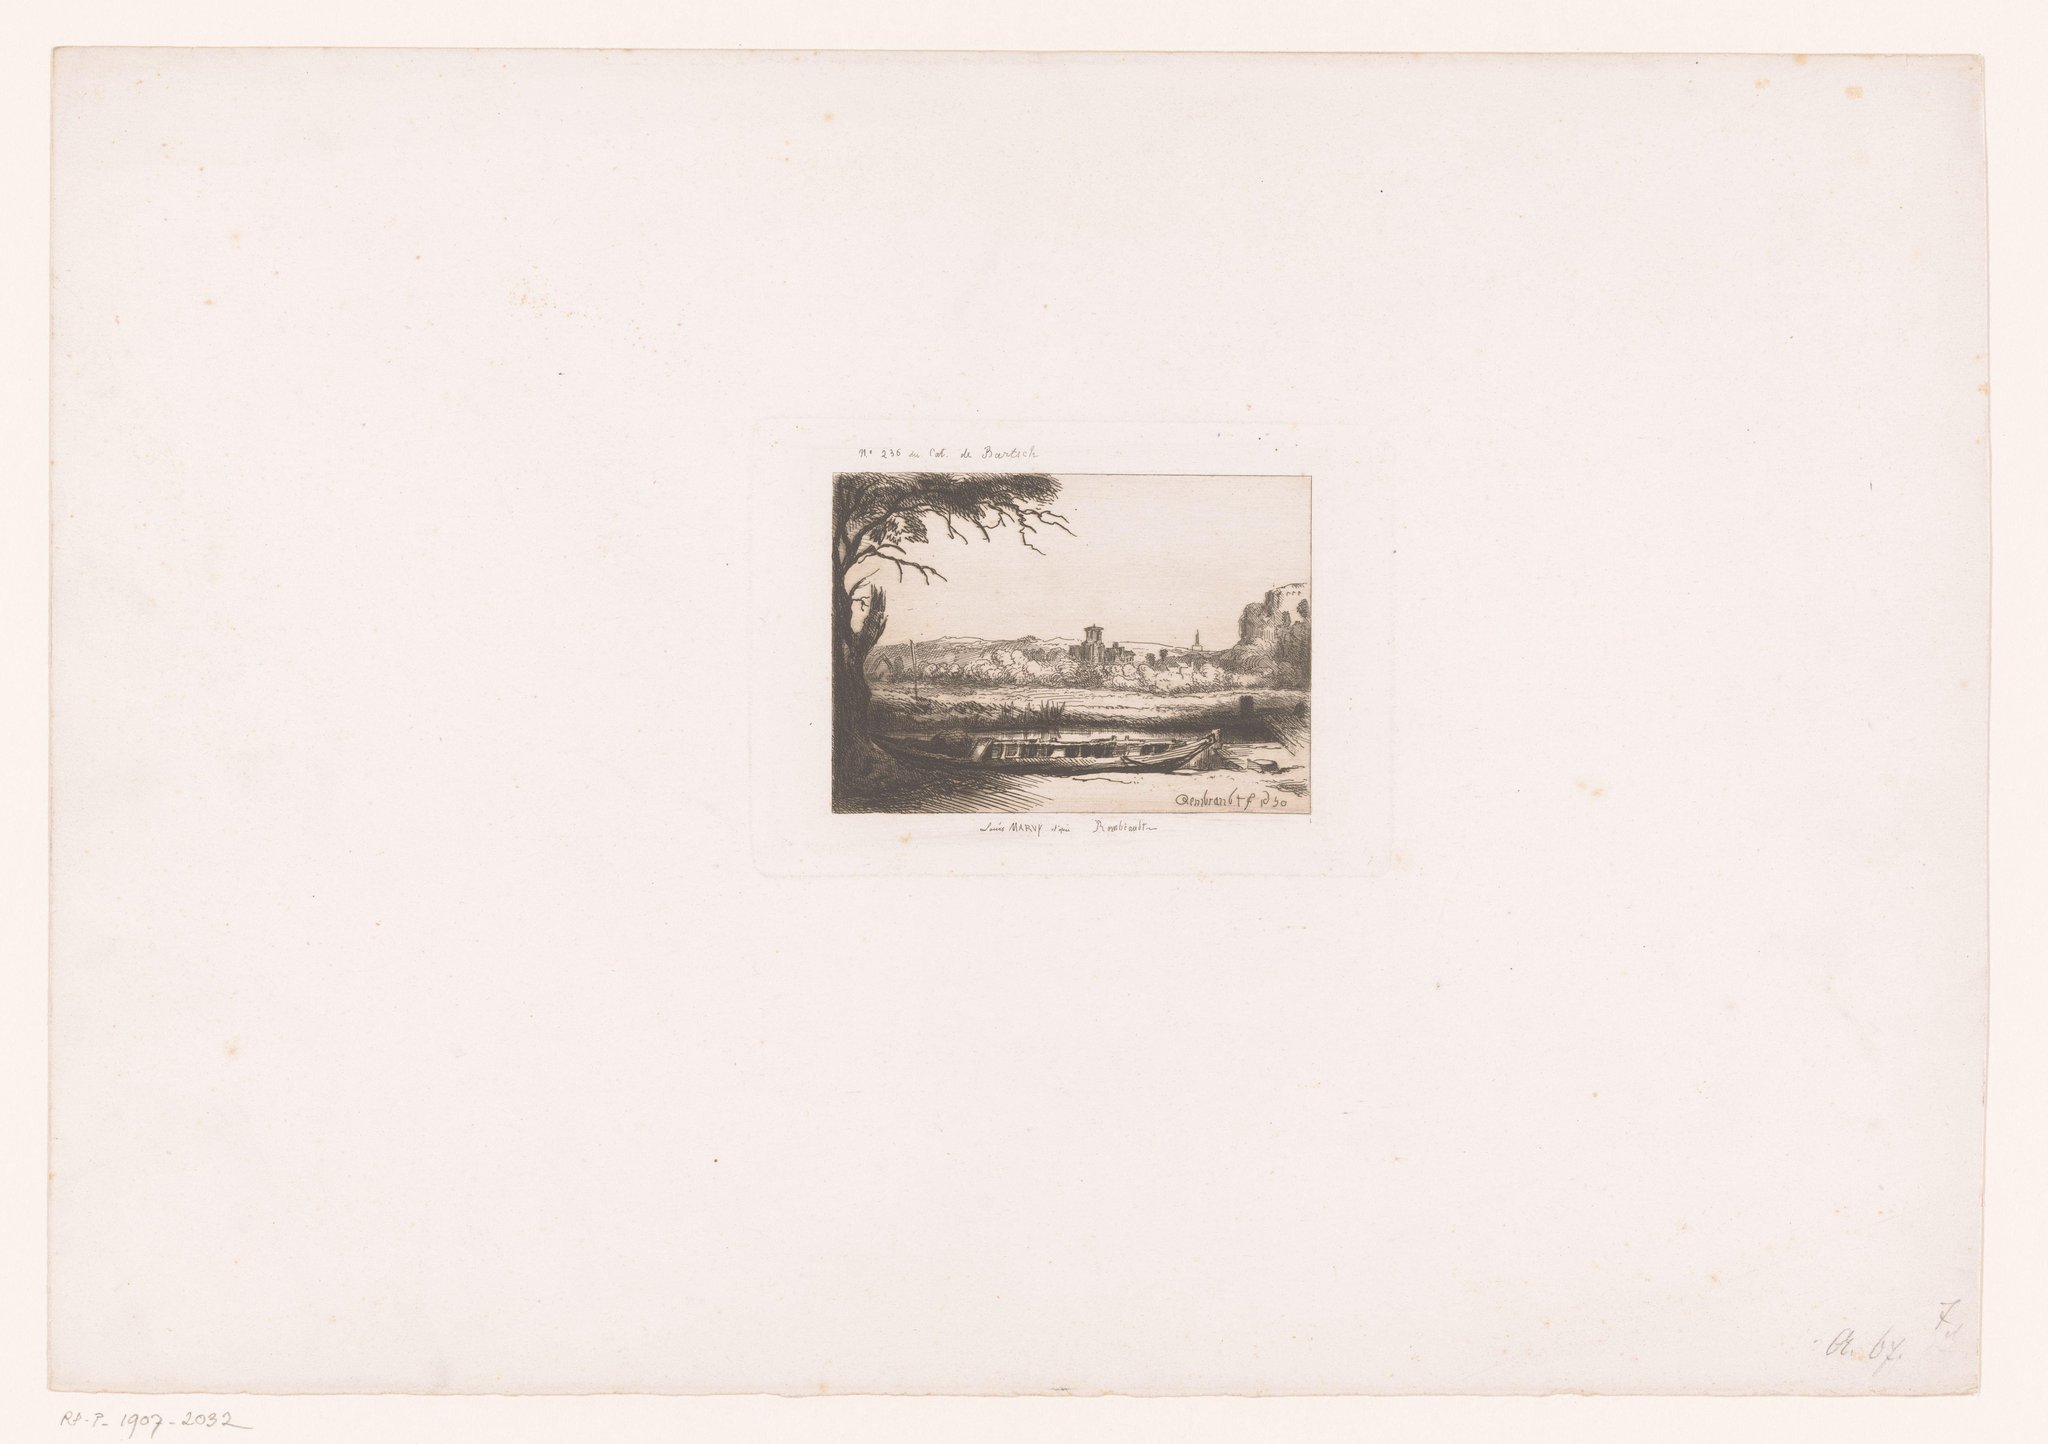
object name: print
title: Vaart met roeiboot en brug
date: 1825-1850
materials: paper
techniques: etching, intaglio, roulette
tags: landscapes, rowing-boat, canoe, etc., bridge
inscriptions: collector's mark: Lugt 2228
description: Spiegelbeeldige kopie naar de gelijknamige prent van Rembrandt.